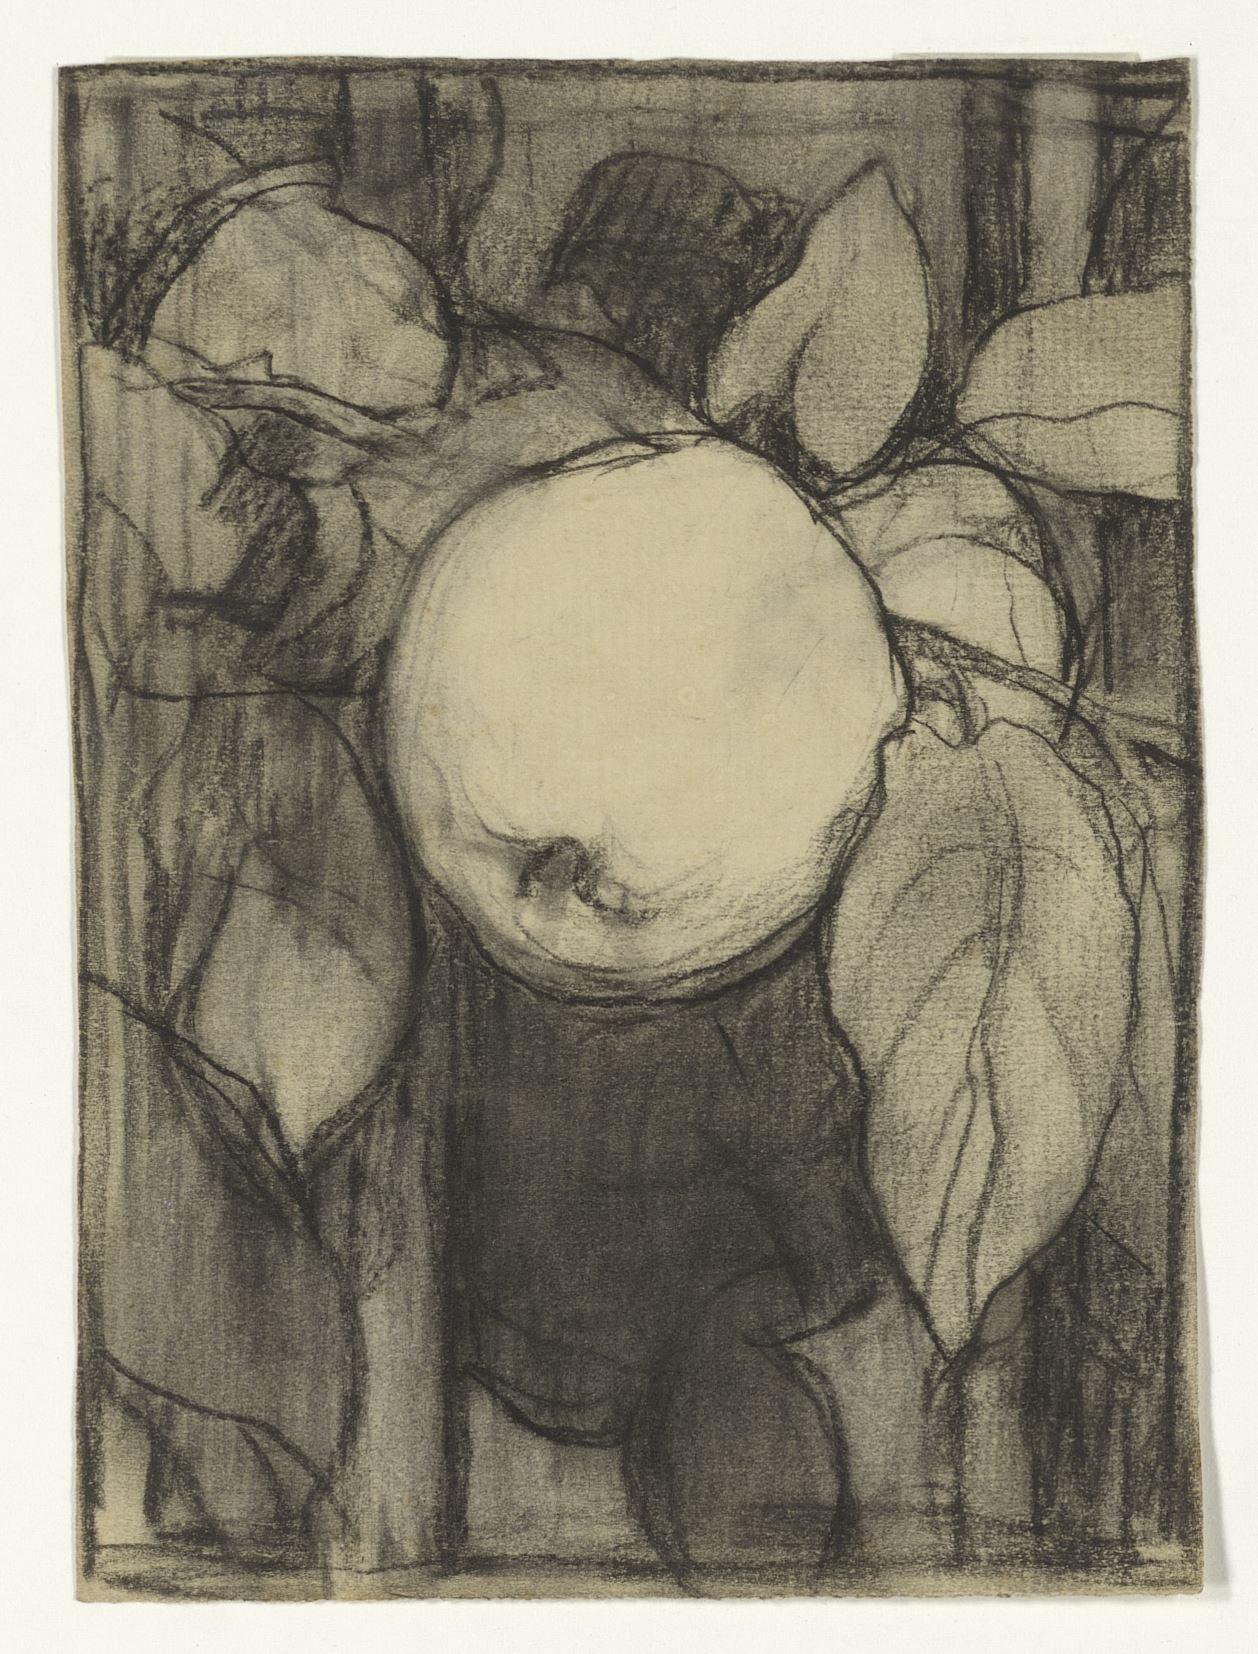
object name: drawing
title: Keizer-Alexander appel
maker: jac van looij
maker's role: draughtsman, painter, print maker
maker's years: 1855-1930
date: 1920-1924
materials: chalk, paper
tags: fruits: apple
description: De huidige titel is door het Rijksmuseum overgenomen van het Instituut Collectie Nederland.